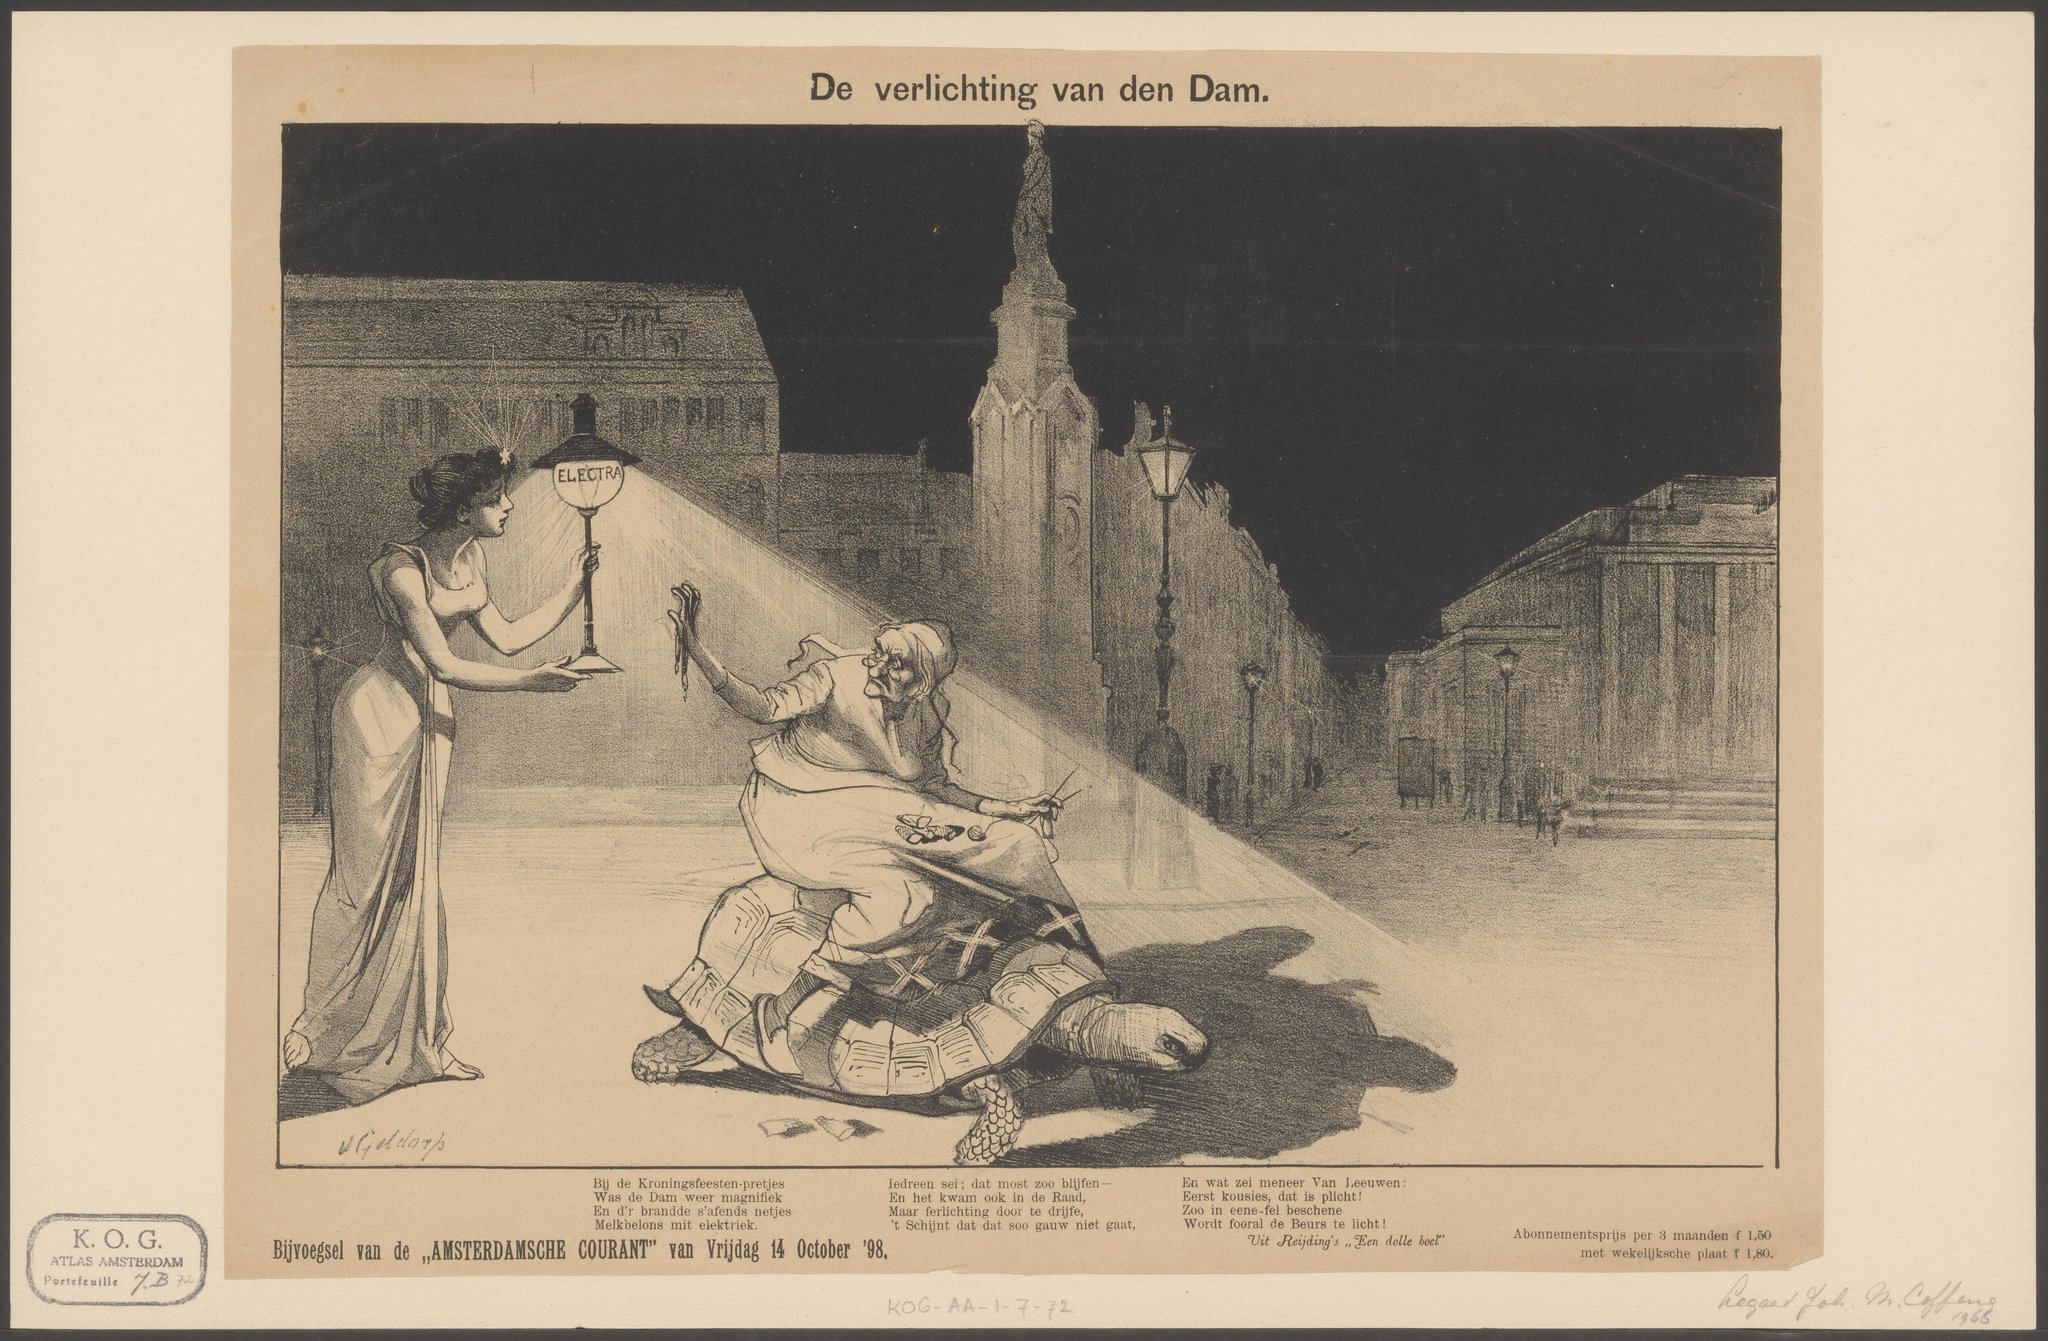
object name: cartoon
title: De verlichting van den Dam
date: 1898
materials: paper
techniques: letterpress printing, lithograph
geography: amsterdam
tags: square, place, circus, etc., city-view in general; 'veduta', artificial light, political caricatures and satires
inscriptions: collector's mark: ‘7B’ Lugt 1641b, inscription: ‘Legaat Joh. M. Coffeng’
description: Bijvoegsel uit: Amsterdamsche Courant (1898), 14 oktober 1898.